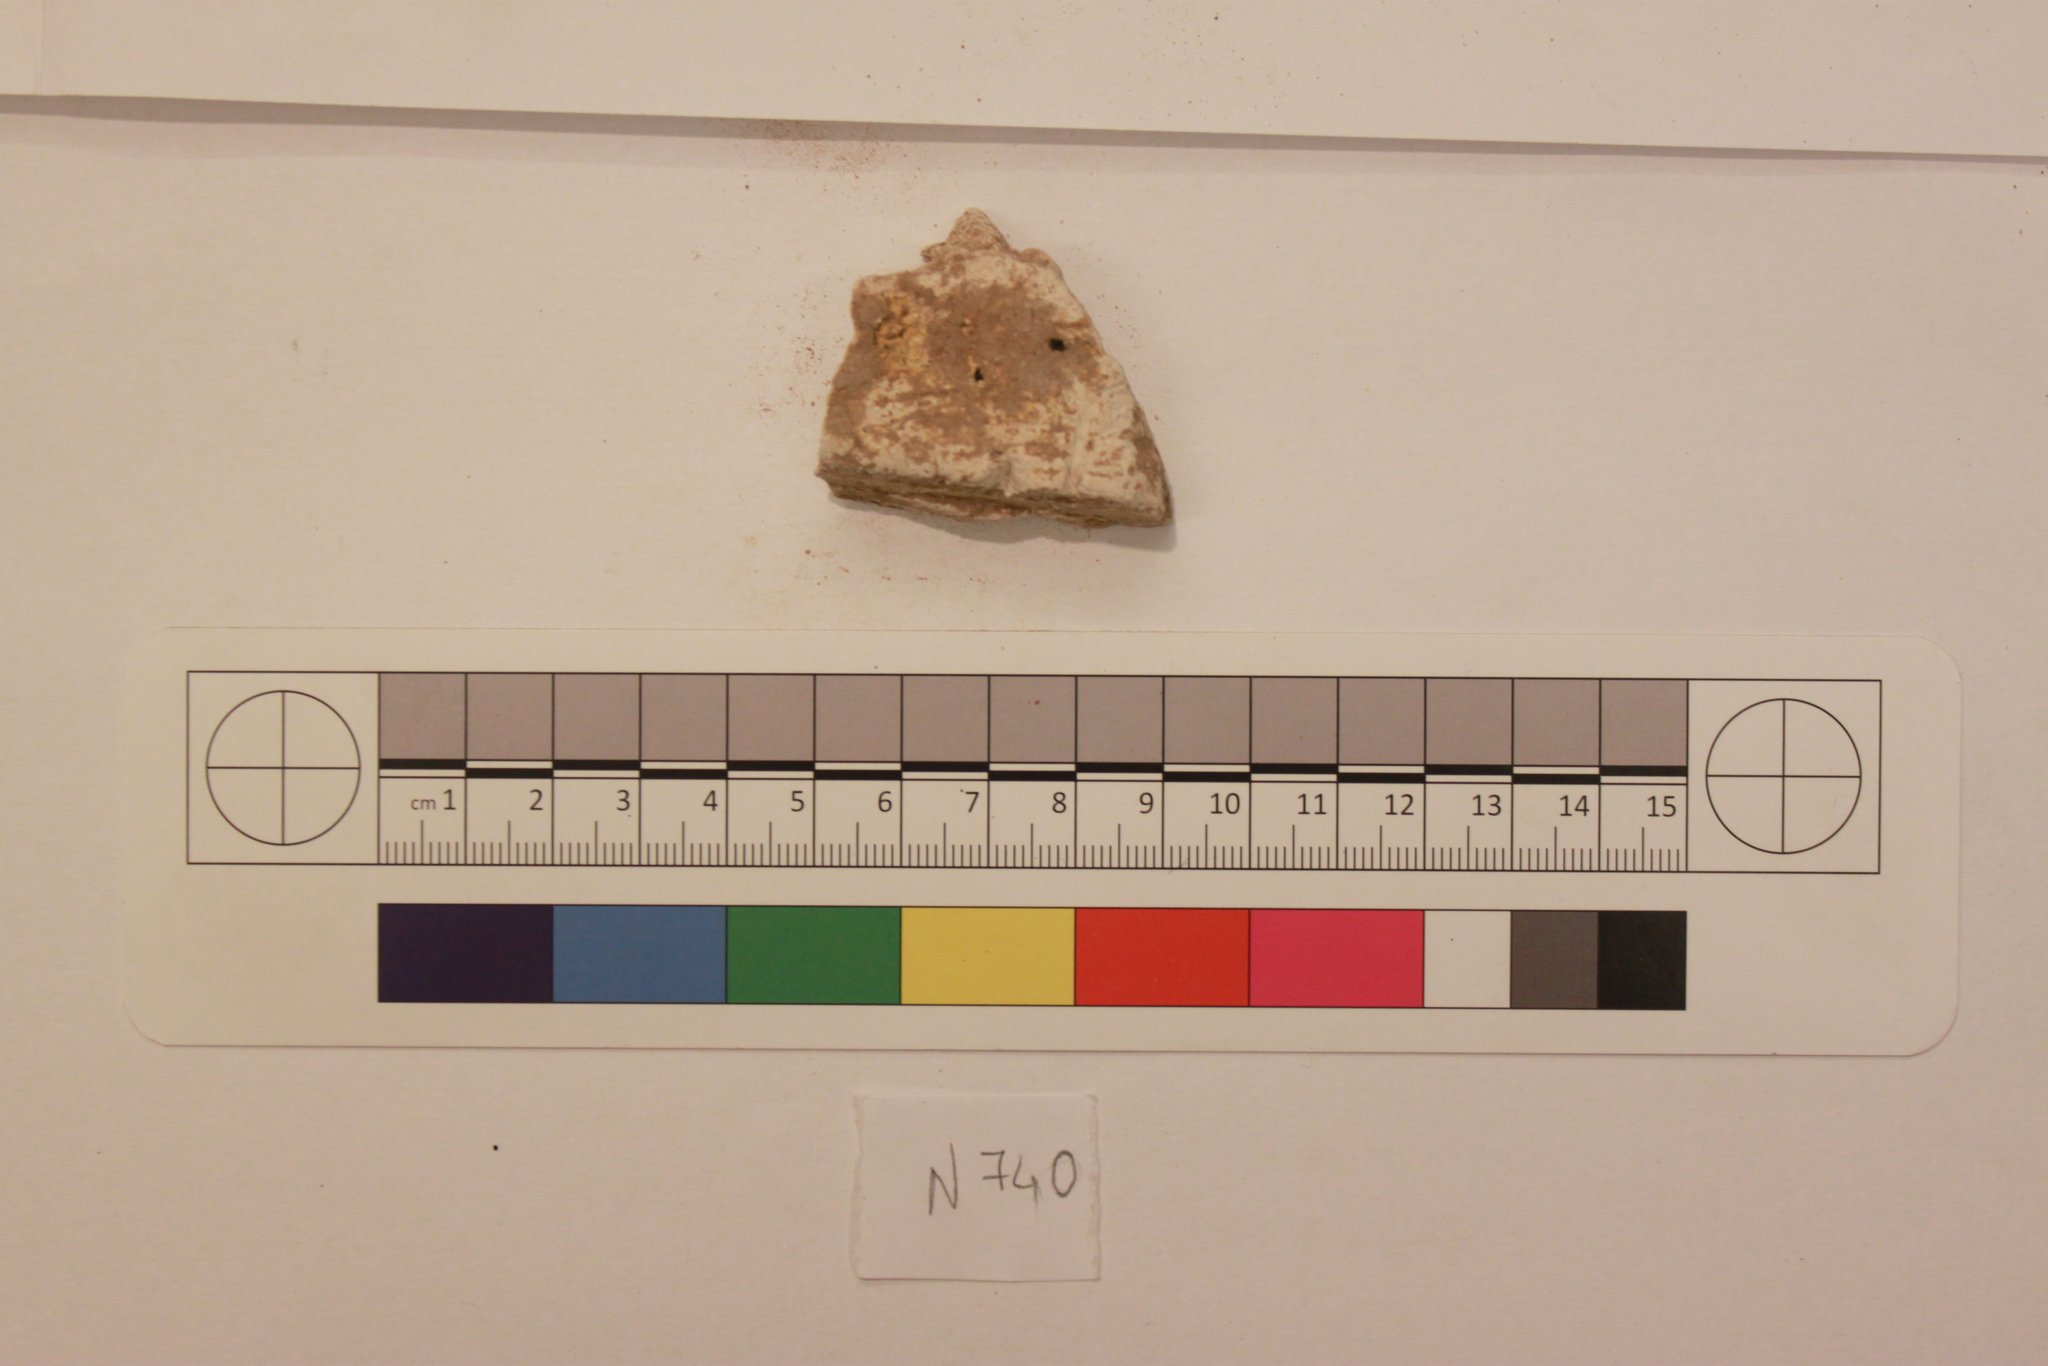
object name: fragment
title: Stucco Fragment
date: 701-1200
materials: plaster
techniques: carving, painting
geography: iran